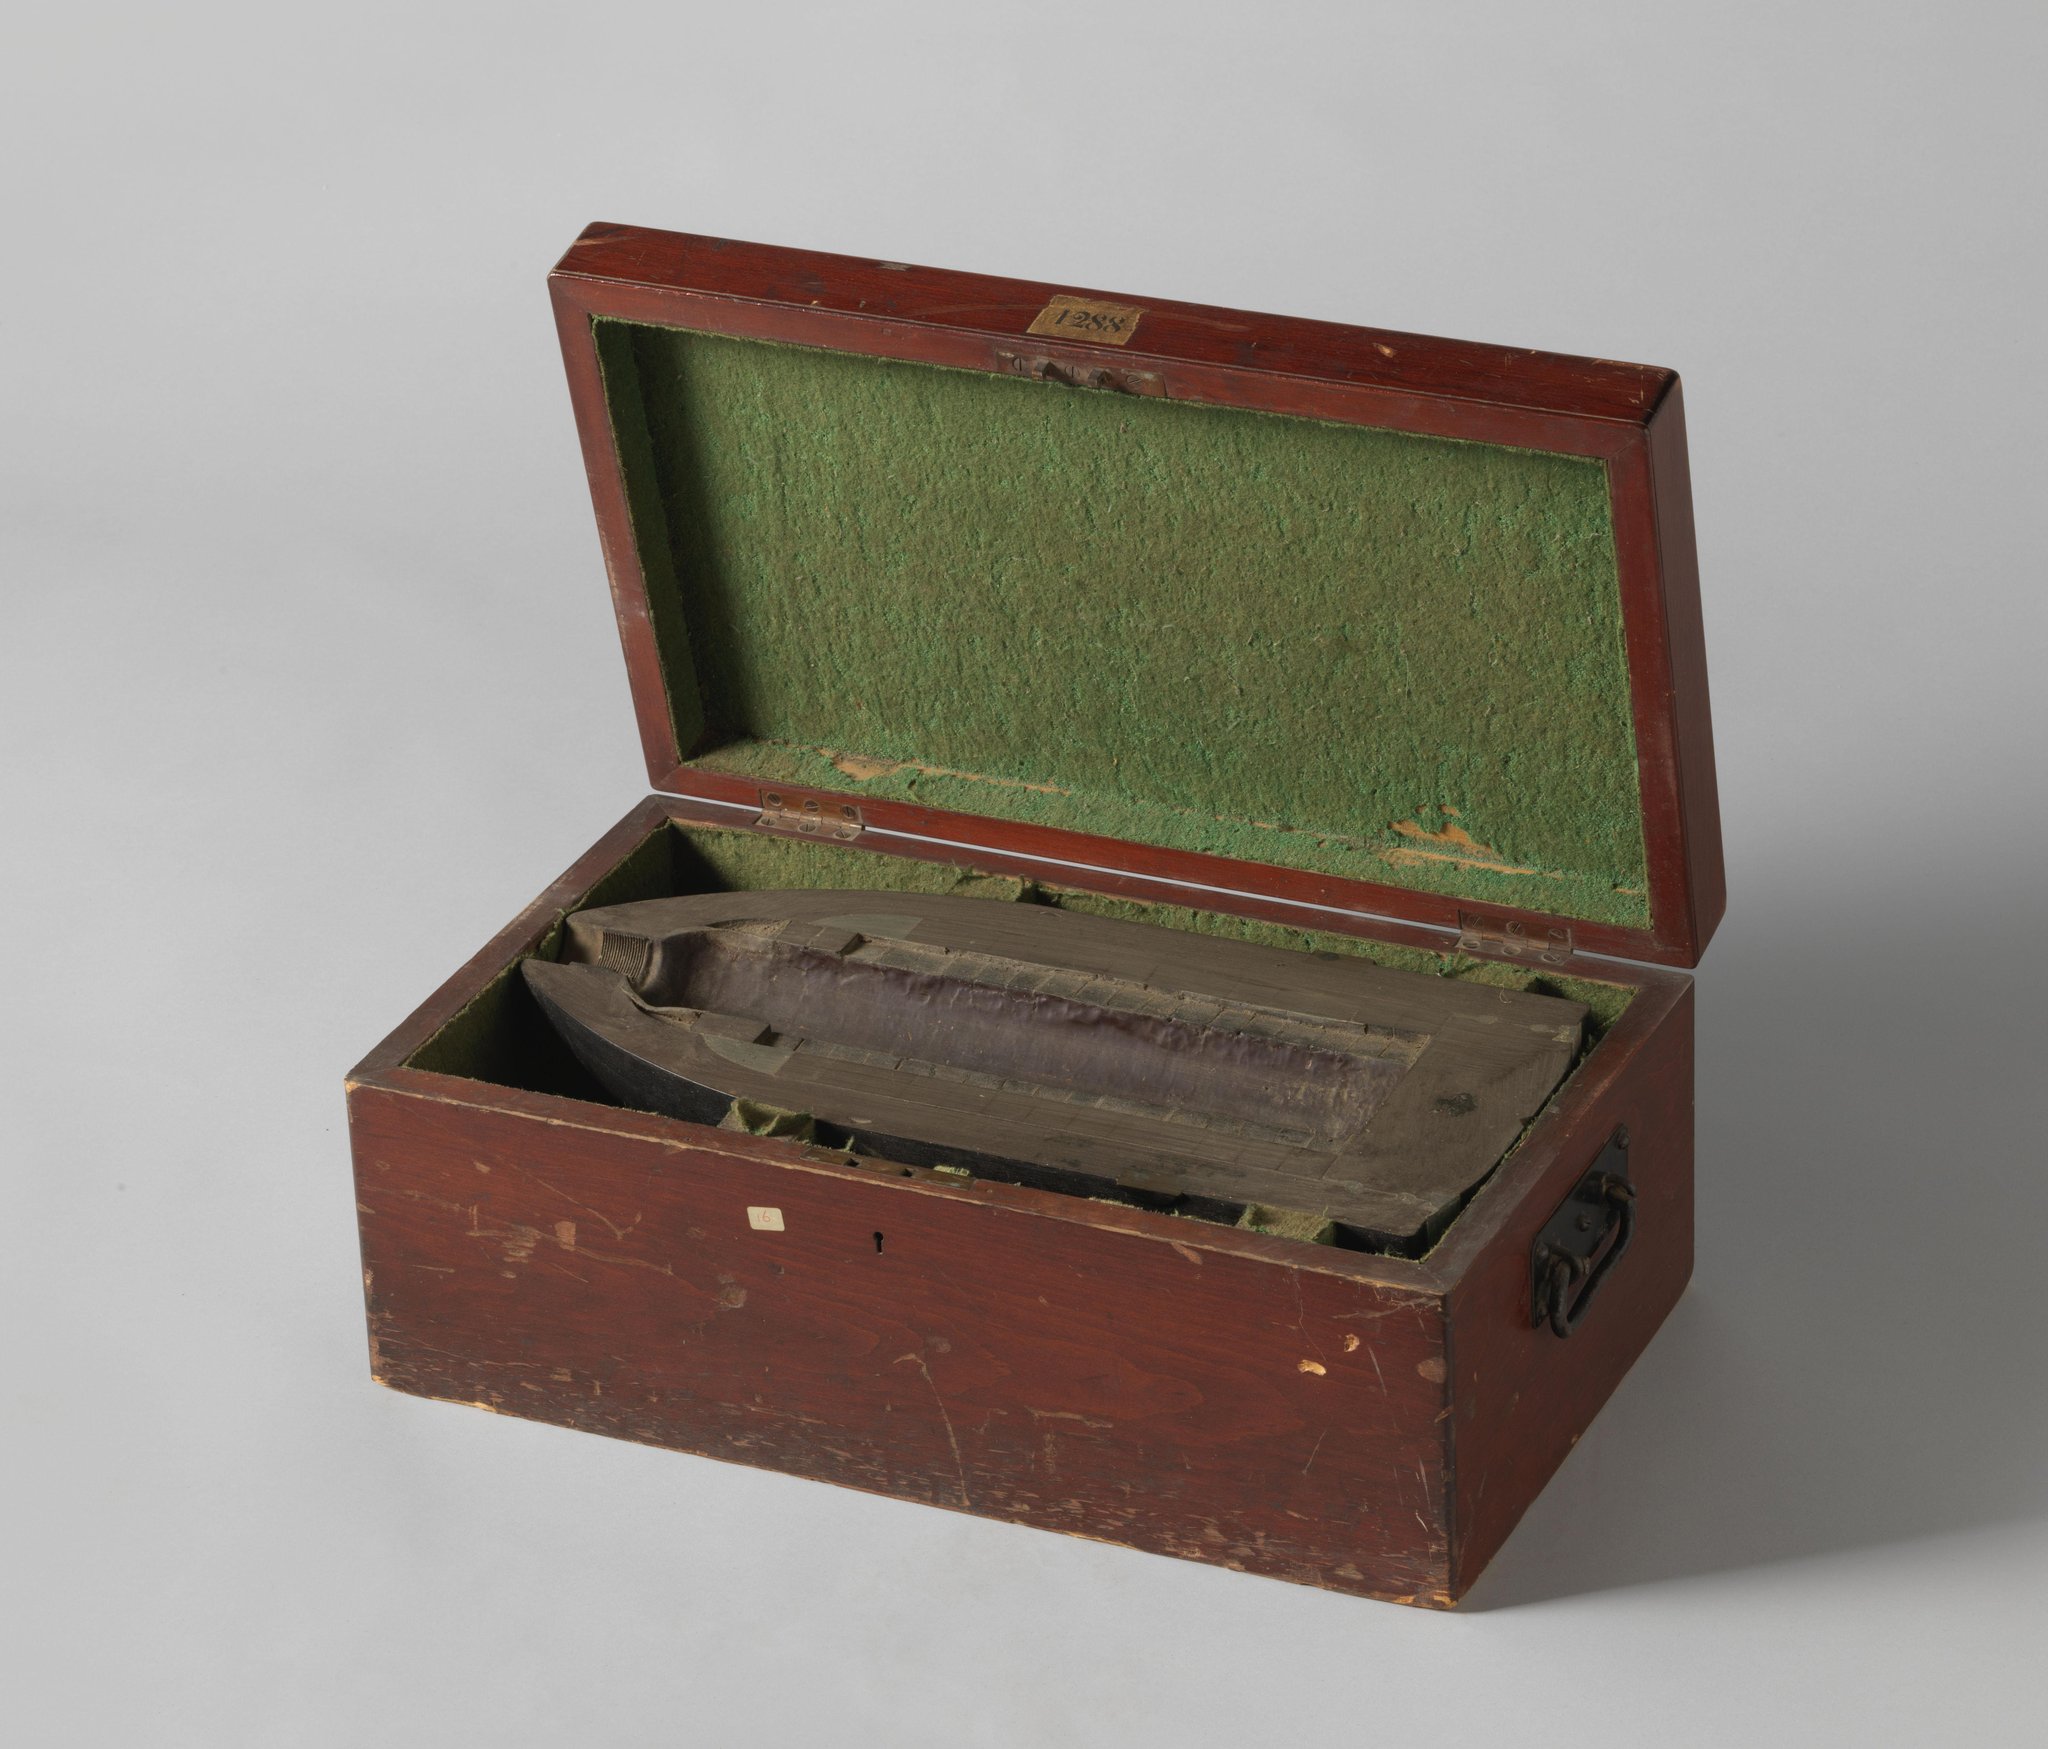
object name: chest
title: 23-cm Segment Shell in a Wooden Box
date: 1868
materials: brass, bronze, iron, lead, wood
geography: newcastle upon tyne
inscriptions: inscription, on the lock of the box: ‘John Shaw & Sons / Wolverhampton / Safety patent lever lock.’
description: Een halve overlangs doormidden gezaagde puntvormige 23 cm granaat, in een houten kist. De granaat is 51.8 cm lang en heeft een kaliber van 226 mm. Hij heeft twee ringen bronzen nokken voor een getrokken loop met zes trekkende velden. De neus heeft een buisgat. De granaat is hol: de springlading is omgeven door dertien buiten-segmentringen, waarin negentien binnen-segmentringen, met lood aaneengekit. De ingezette bodem is tevens met loden ringen vastgemaakt.